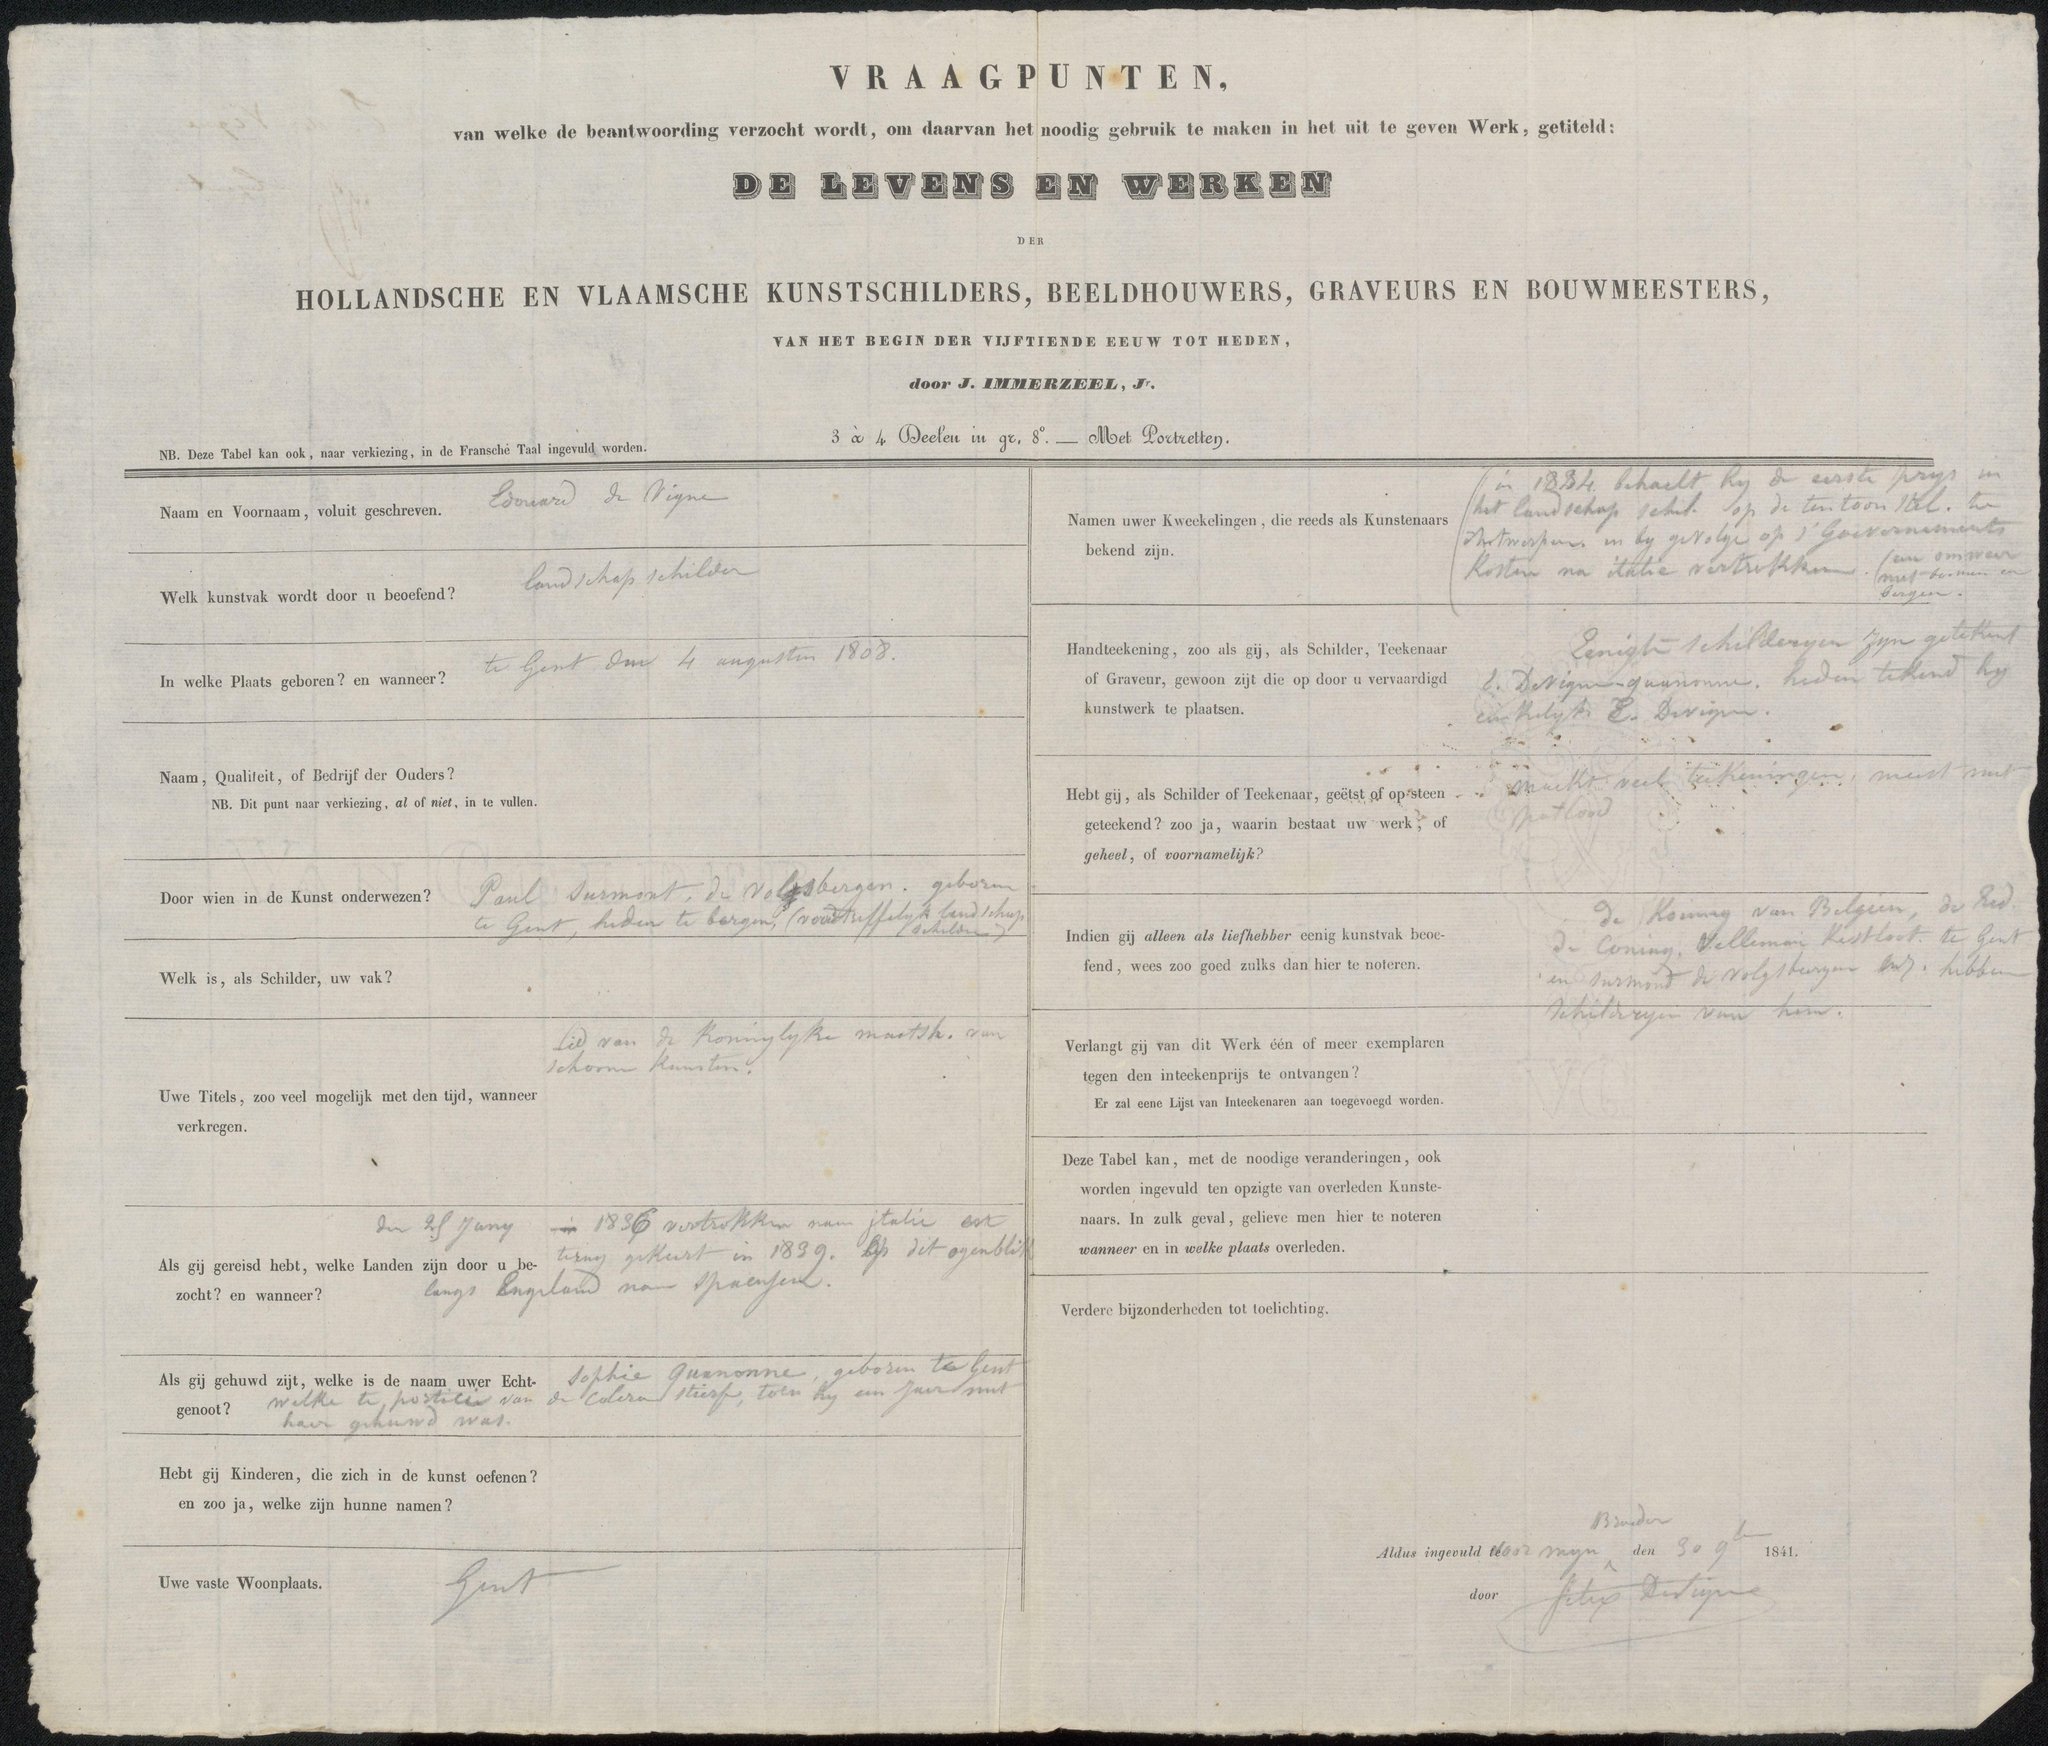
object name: questionnaire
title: Enquêteformulier betreffende Edouard De Vigne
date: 1841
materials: paper, pencil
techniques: printing, writing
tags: ghent, print maker, edouard de vigne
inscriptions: inscription: ‘Vraagpunten,/ van welke de beantwoording verzocht wordt, om daarvan het noodig gebruik te maken in het uit te geven Werk, getiteld: De levens en werken/ der Hollandsche en Vlaamsche kunstschilders, beeldhouwers,/ graveurs en bouwmeesters, van het begin der vijftiende eeuw tot heden/ door J. Immerzeel, Jr.’, watermark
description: Opgenomen in: Immerzeel, J. Jr., De levens en werken der Hollandsche en Vlaamsche kunstschilders, beeldhouwers, graveurs en bouwmeesters, van het begin der vijftiende eeuw tot heden, Amsterdam: J.C. van Kesteren, 1842-1843.